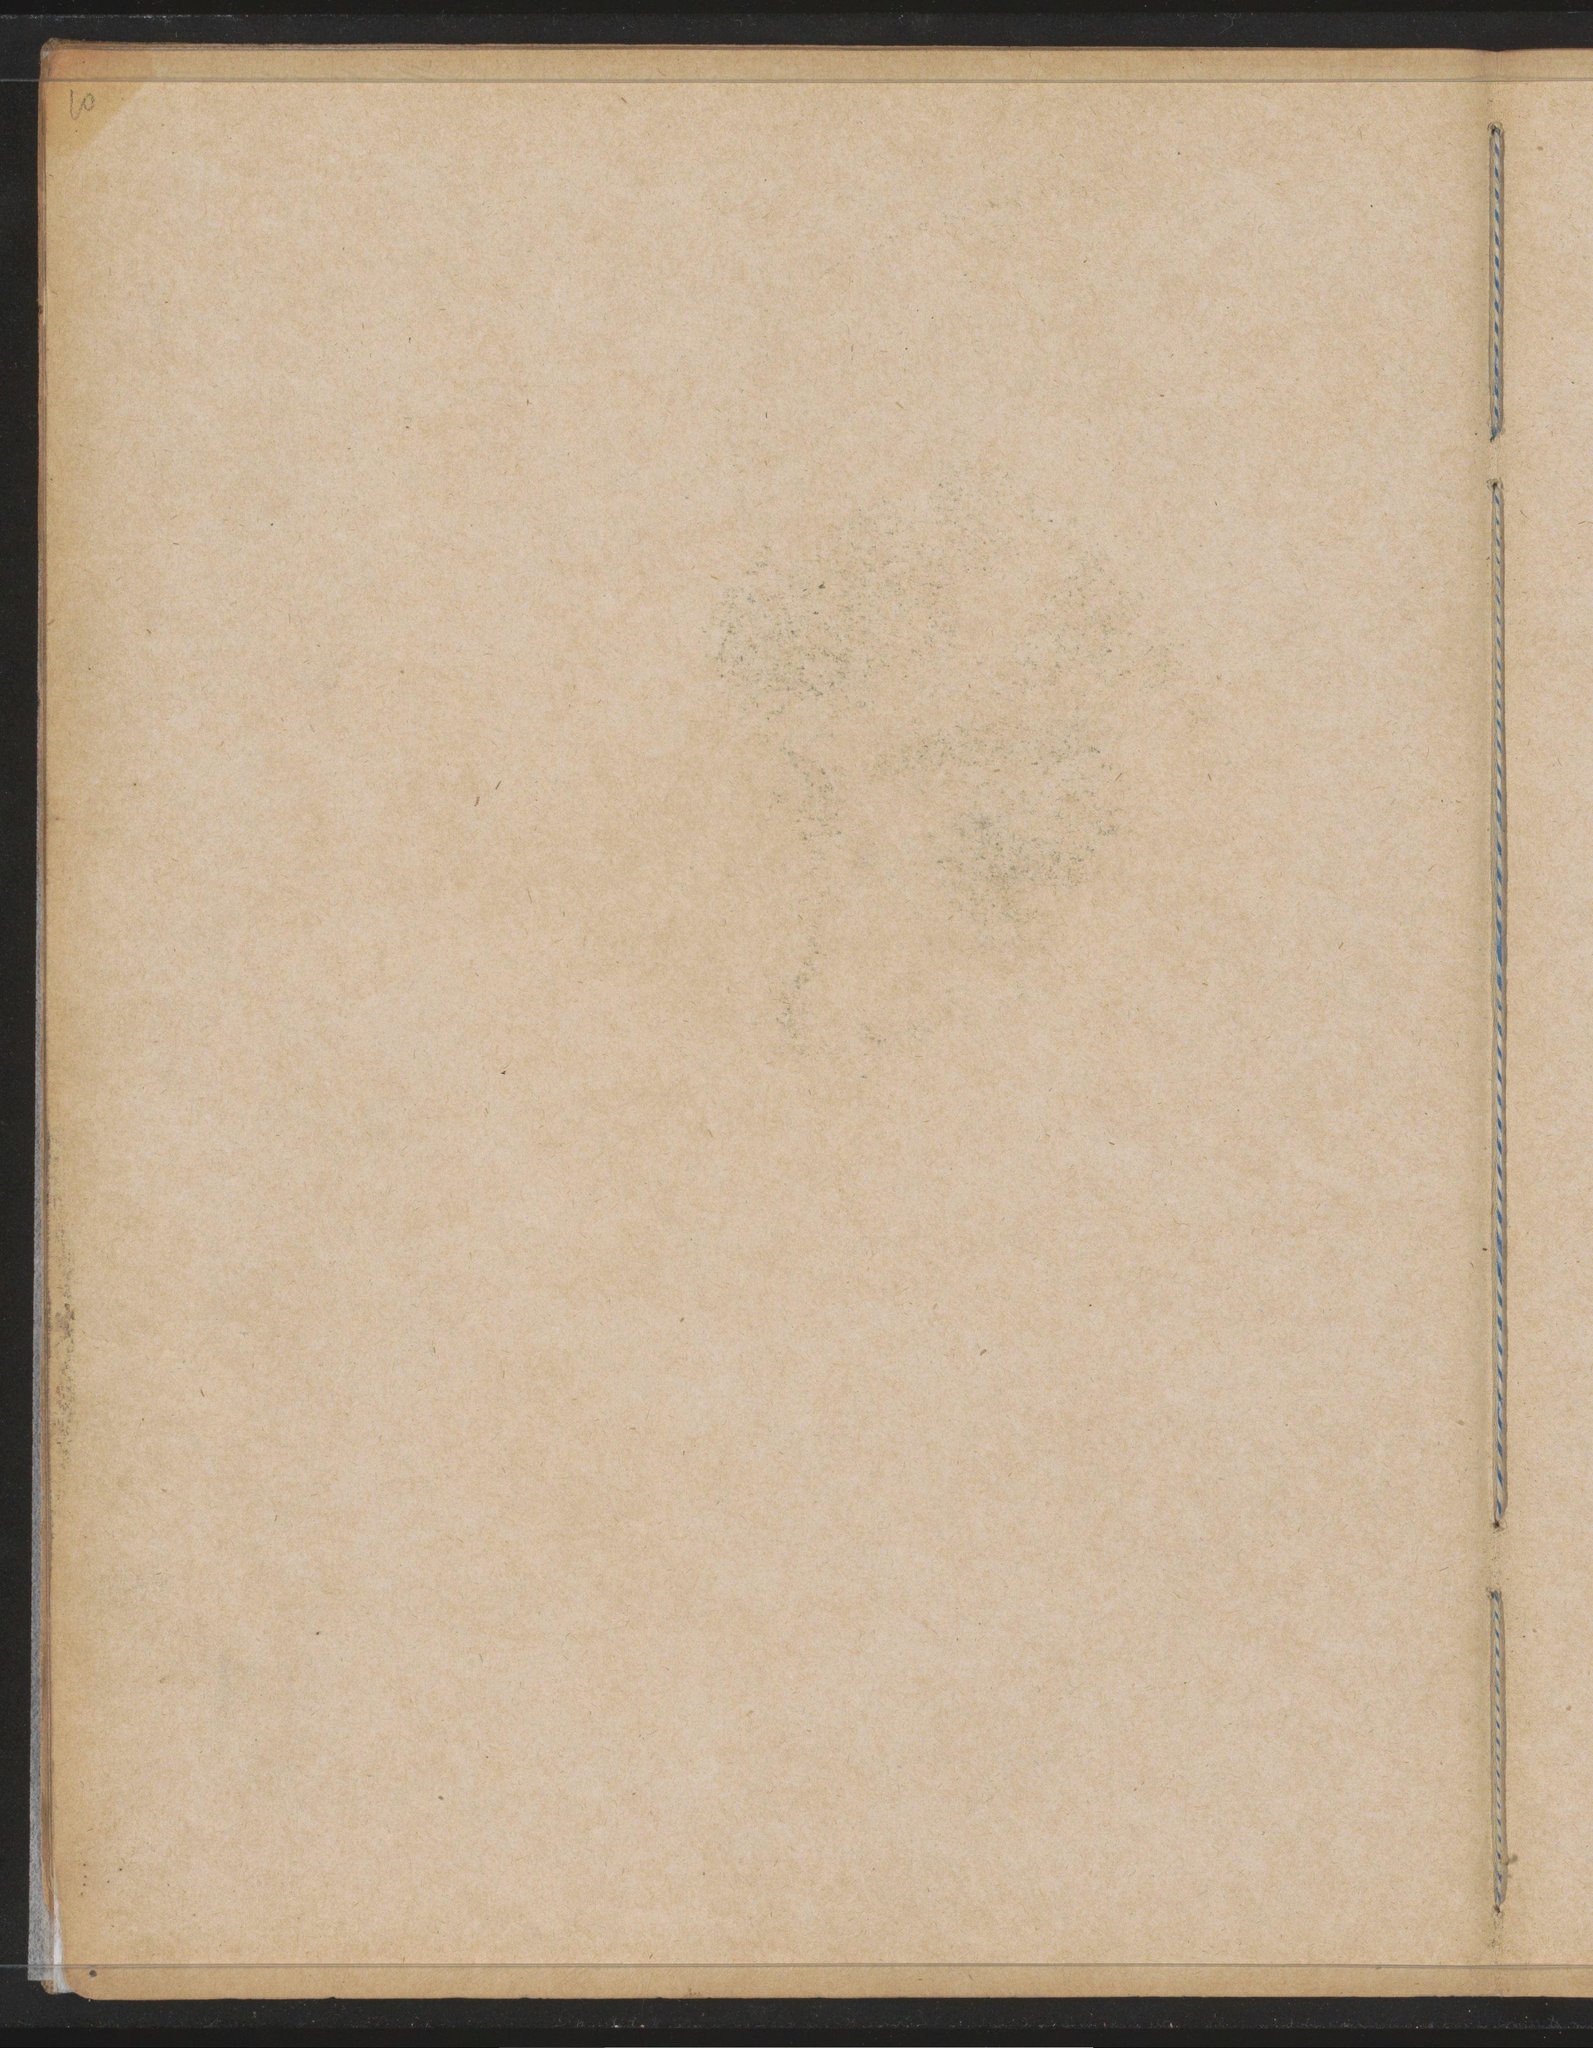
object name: sketchbook leaf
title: Abklatsch van een krijttekening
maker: willem witsen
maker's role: draughtsman, painter, print maker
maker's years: 1860-1923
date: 1887-1888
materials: paper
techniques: printmaking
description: Pagina 10 uit een schetsboek met 43 bladen.